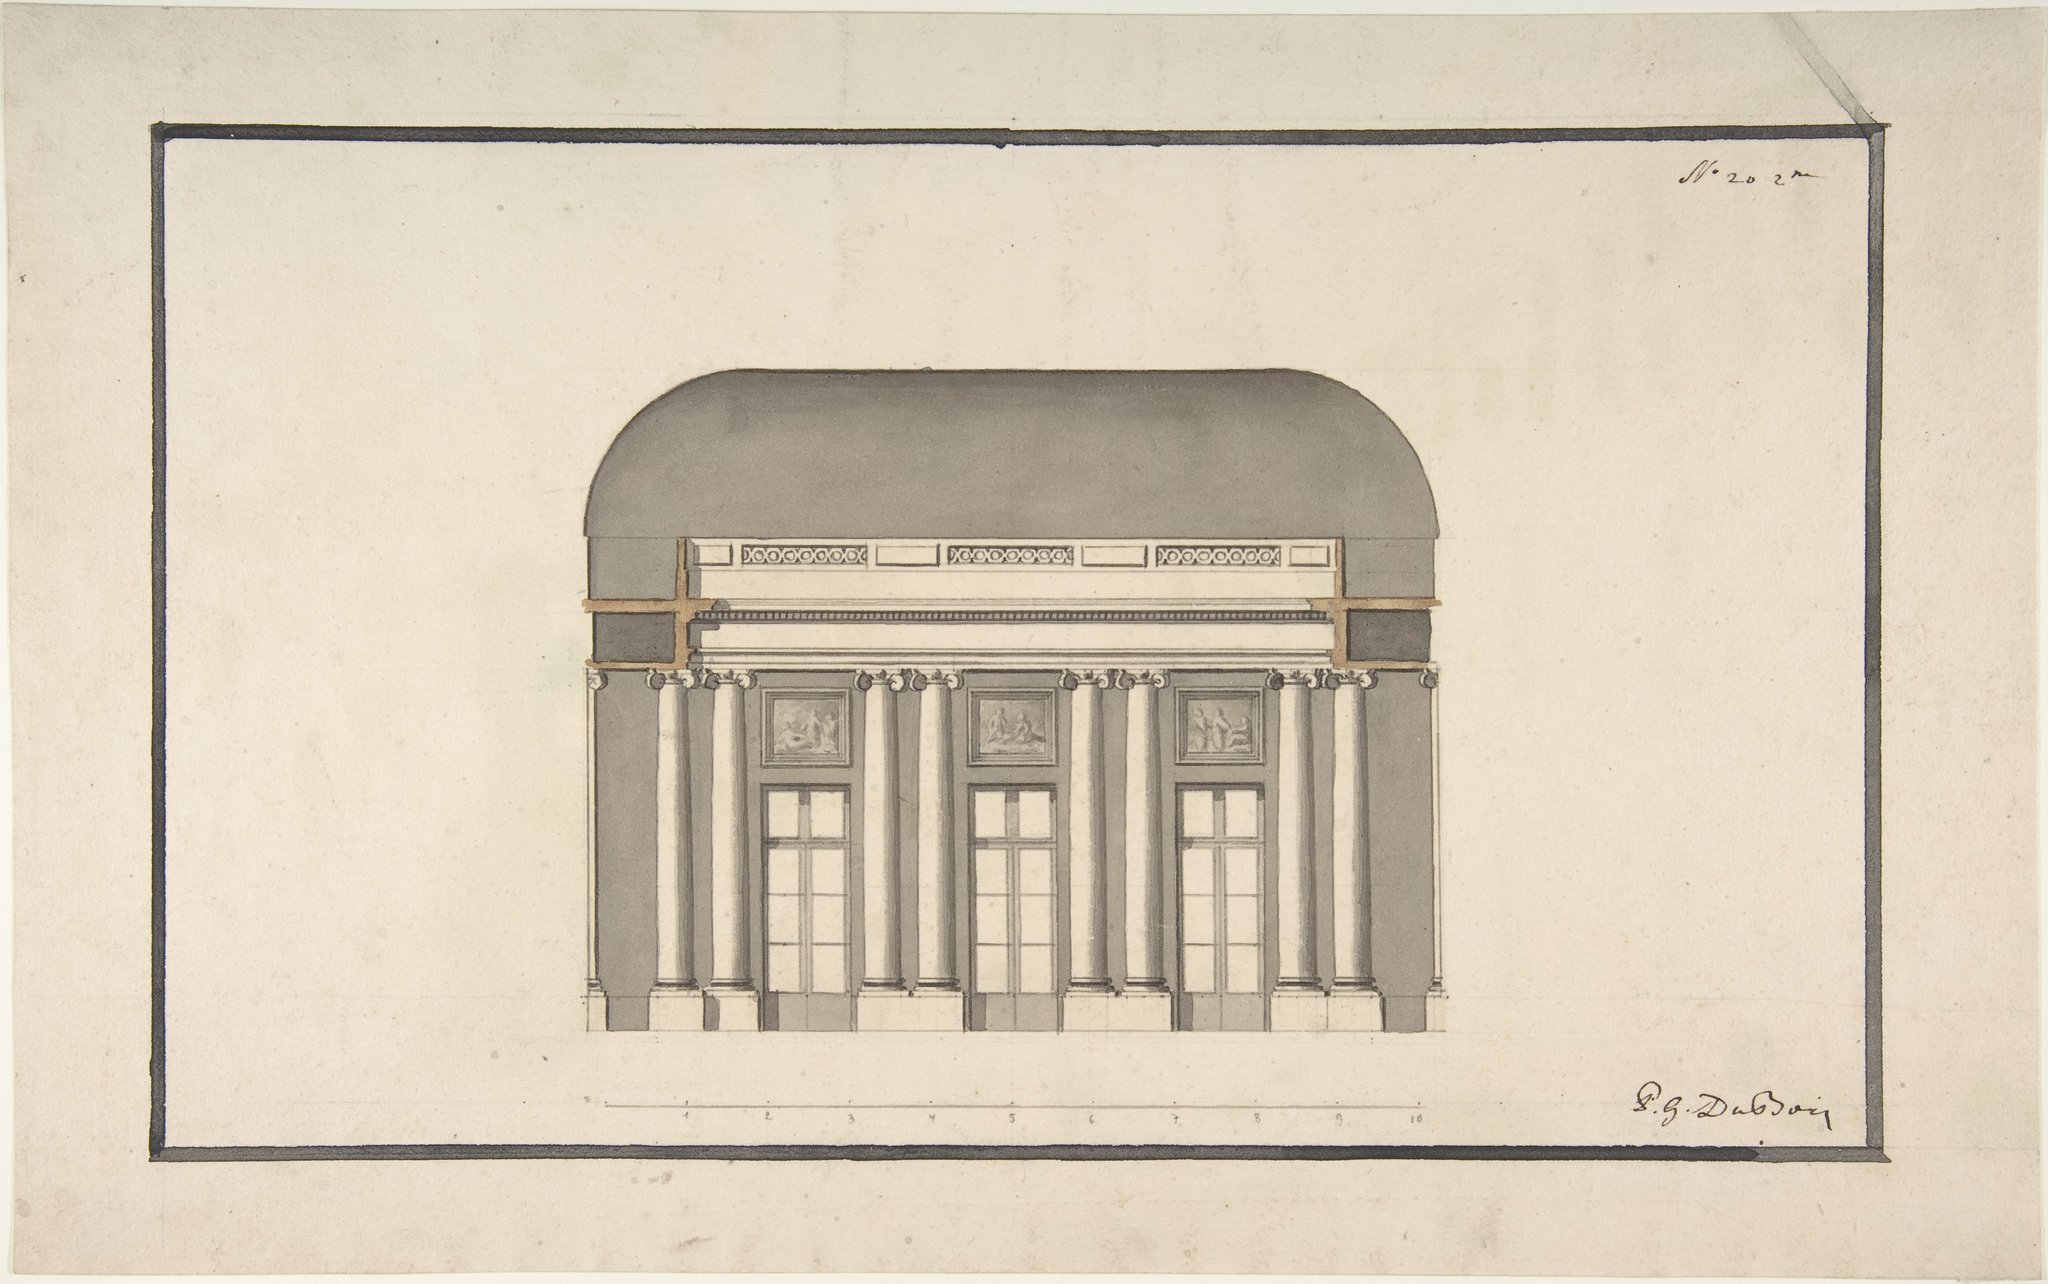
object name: drawing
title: Section of a Ballroom: Three Doorways between Sets of Two Columns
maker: anonymous, french, 18th century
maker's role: artist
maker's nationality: french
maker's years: 1700-1800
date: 1701-1800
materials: ink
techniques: brush, pen, wash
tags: architecture,columns